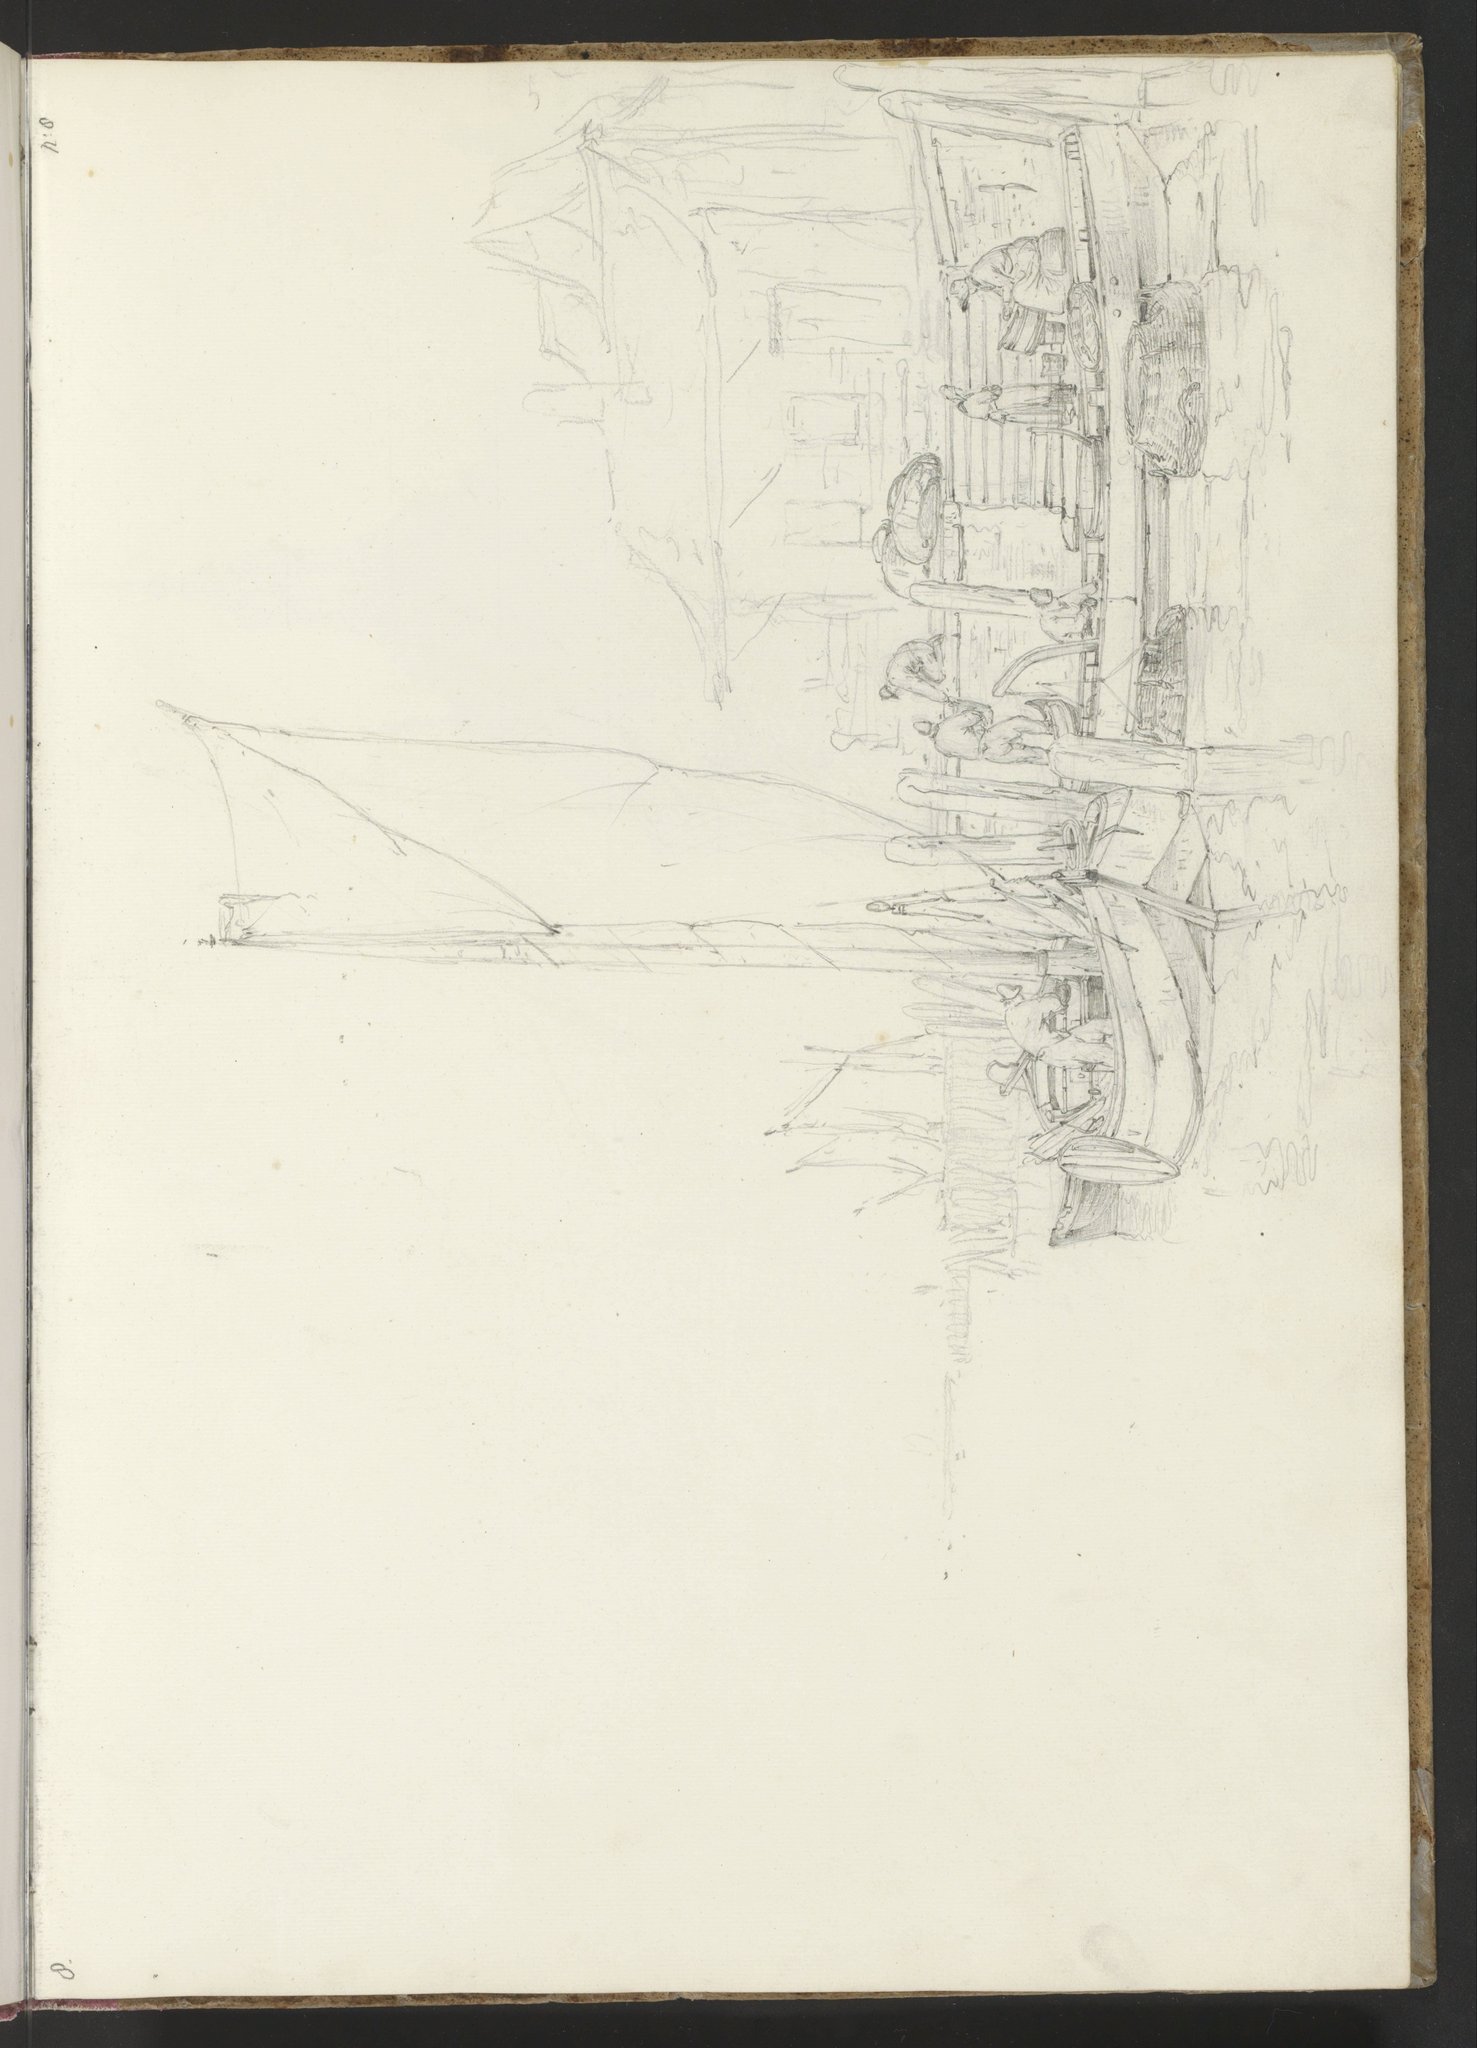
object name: sketchbook leaf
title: Kade met figuren en vissersboten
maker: johannes christiaan schotel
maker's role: draughtsman, painter, print maker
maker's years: 1787-1838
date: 1797-1838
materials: paper, pencil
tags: city-view, and landscape with man-made constructions, sailing-ship, sailing-boat, pier, quay, wharf (+ view ~ vehicle, ship, etc.)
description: Op twee aangemeerde boten zijn vissers in de weer. Op de kade zijn twee figuren (vis)manden aan het lossen. Op de achtergrond een gebouw. Blad 8 recto uit een schetsboek met 65 bladen.